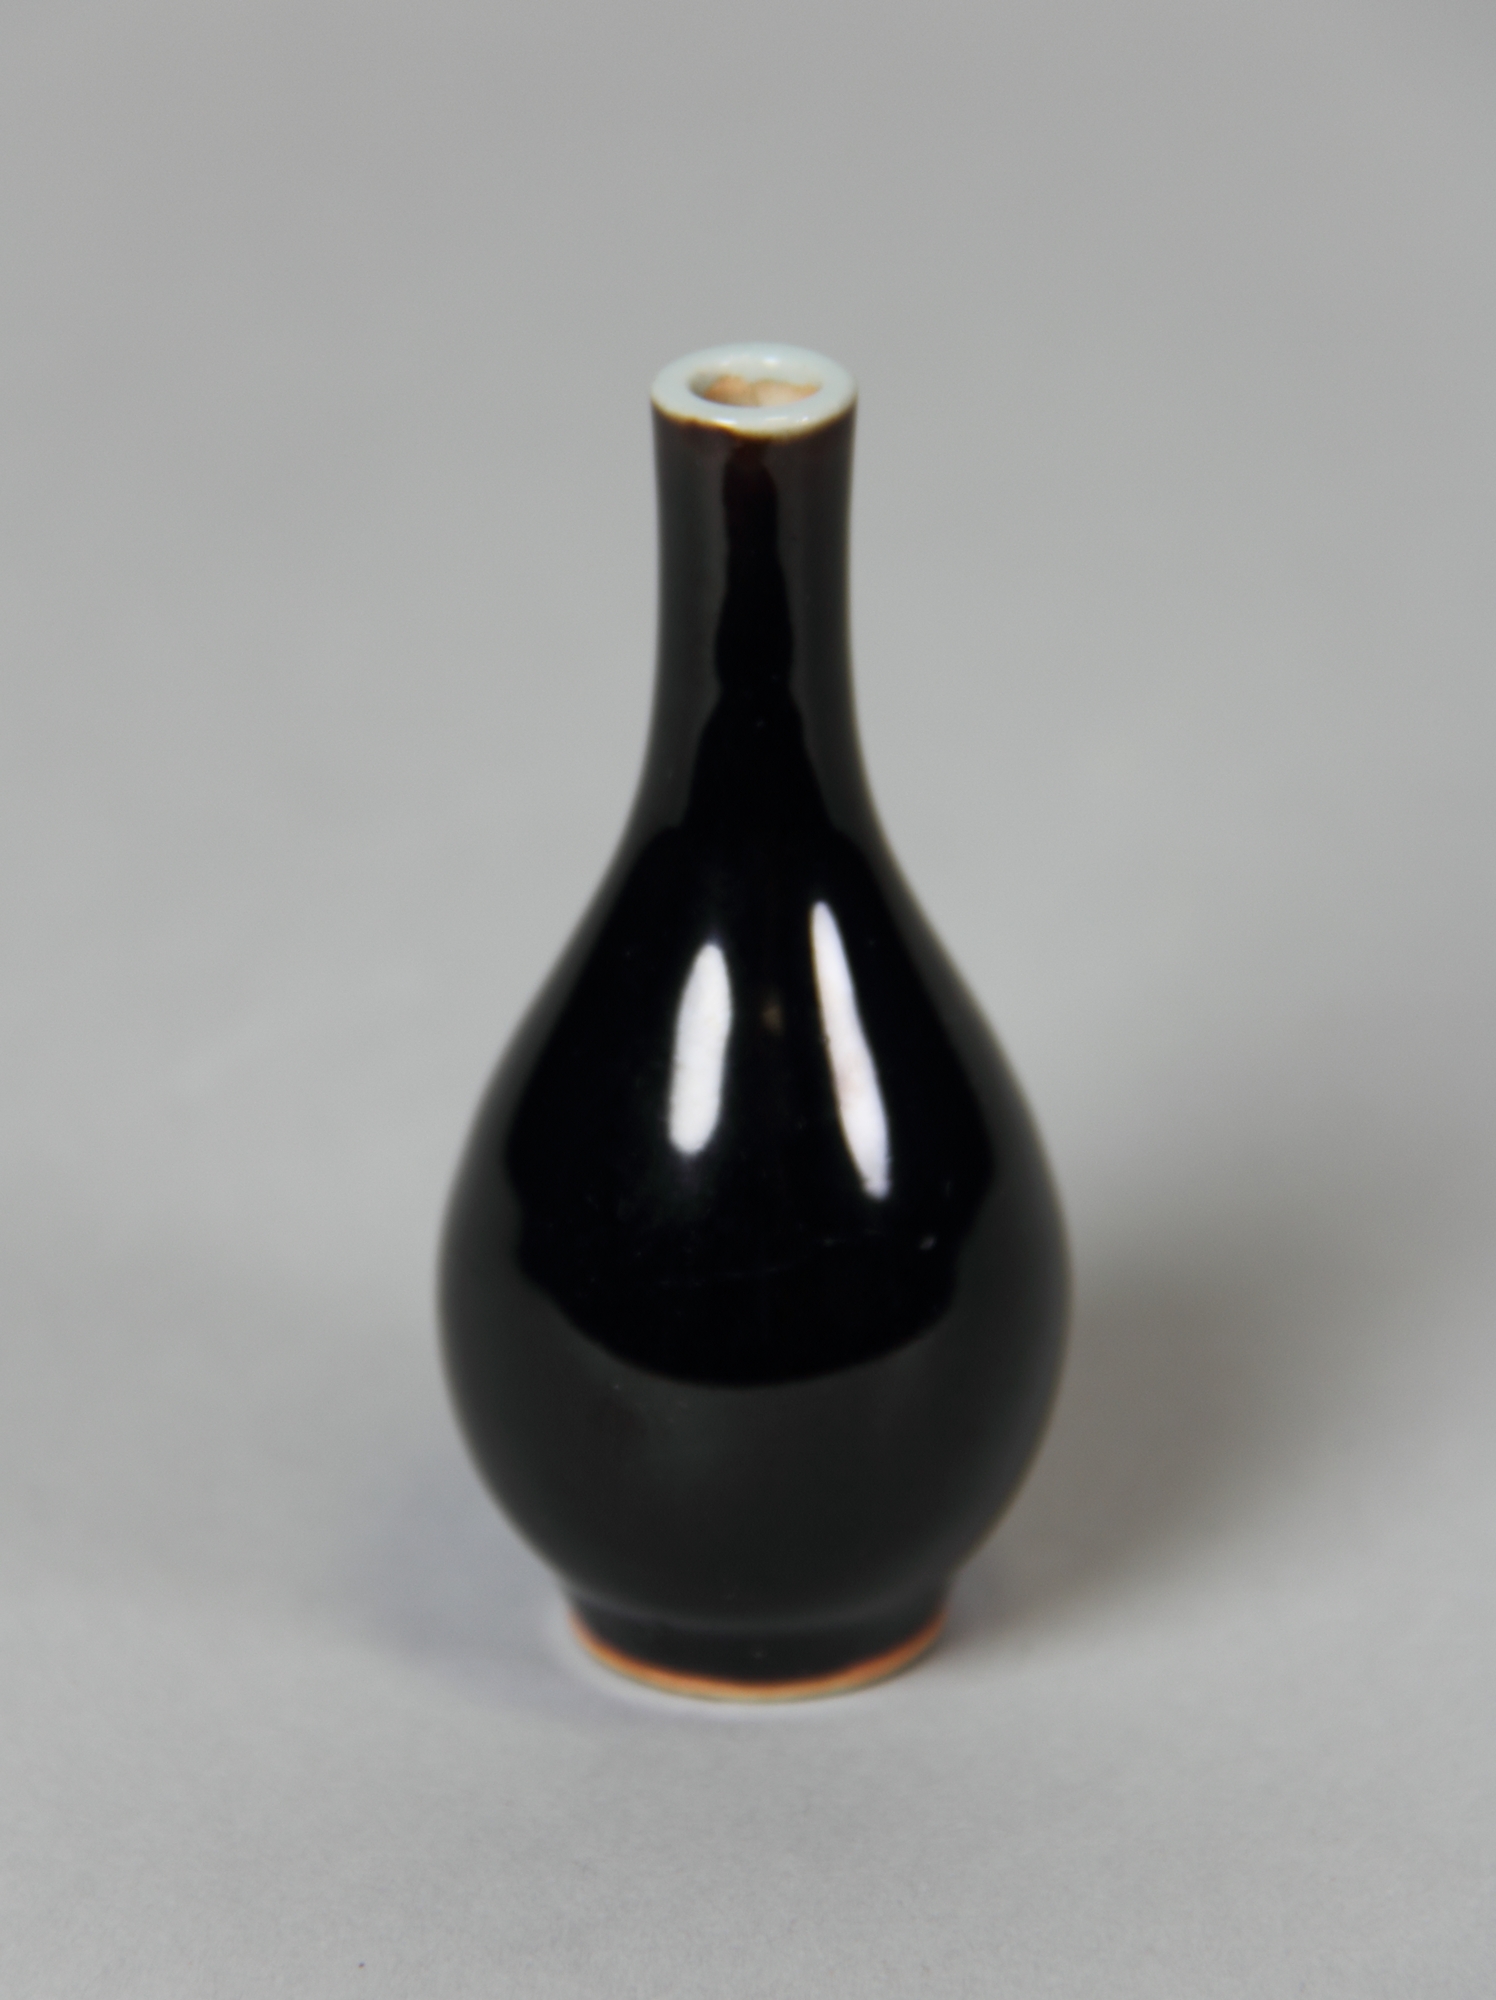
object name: vase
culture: chinese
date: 1701-1733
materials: glaze, porcelain